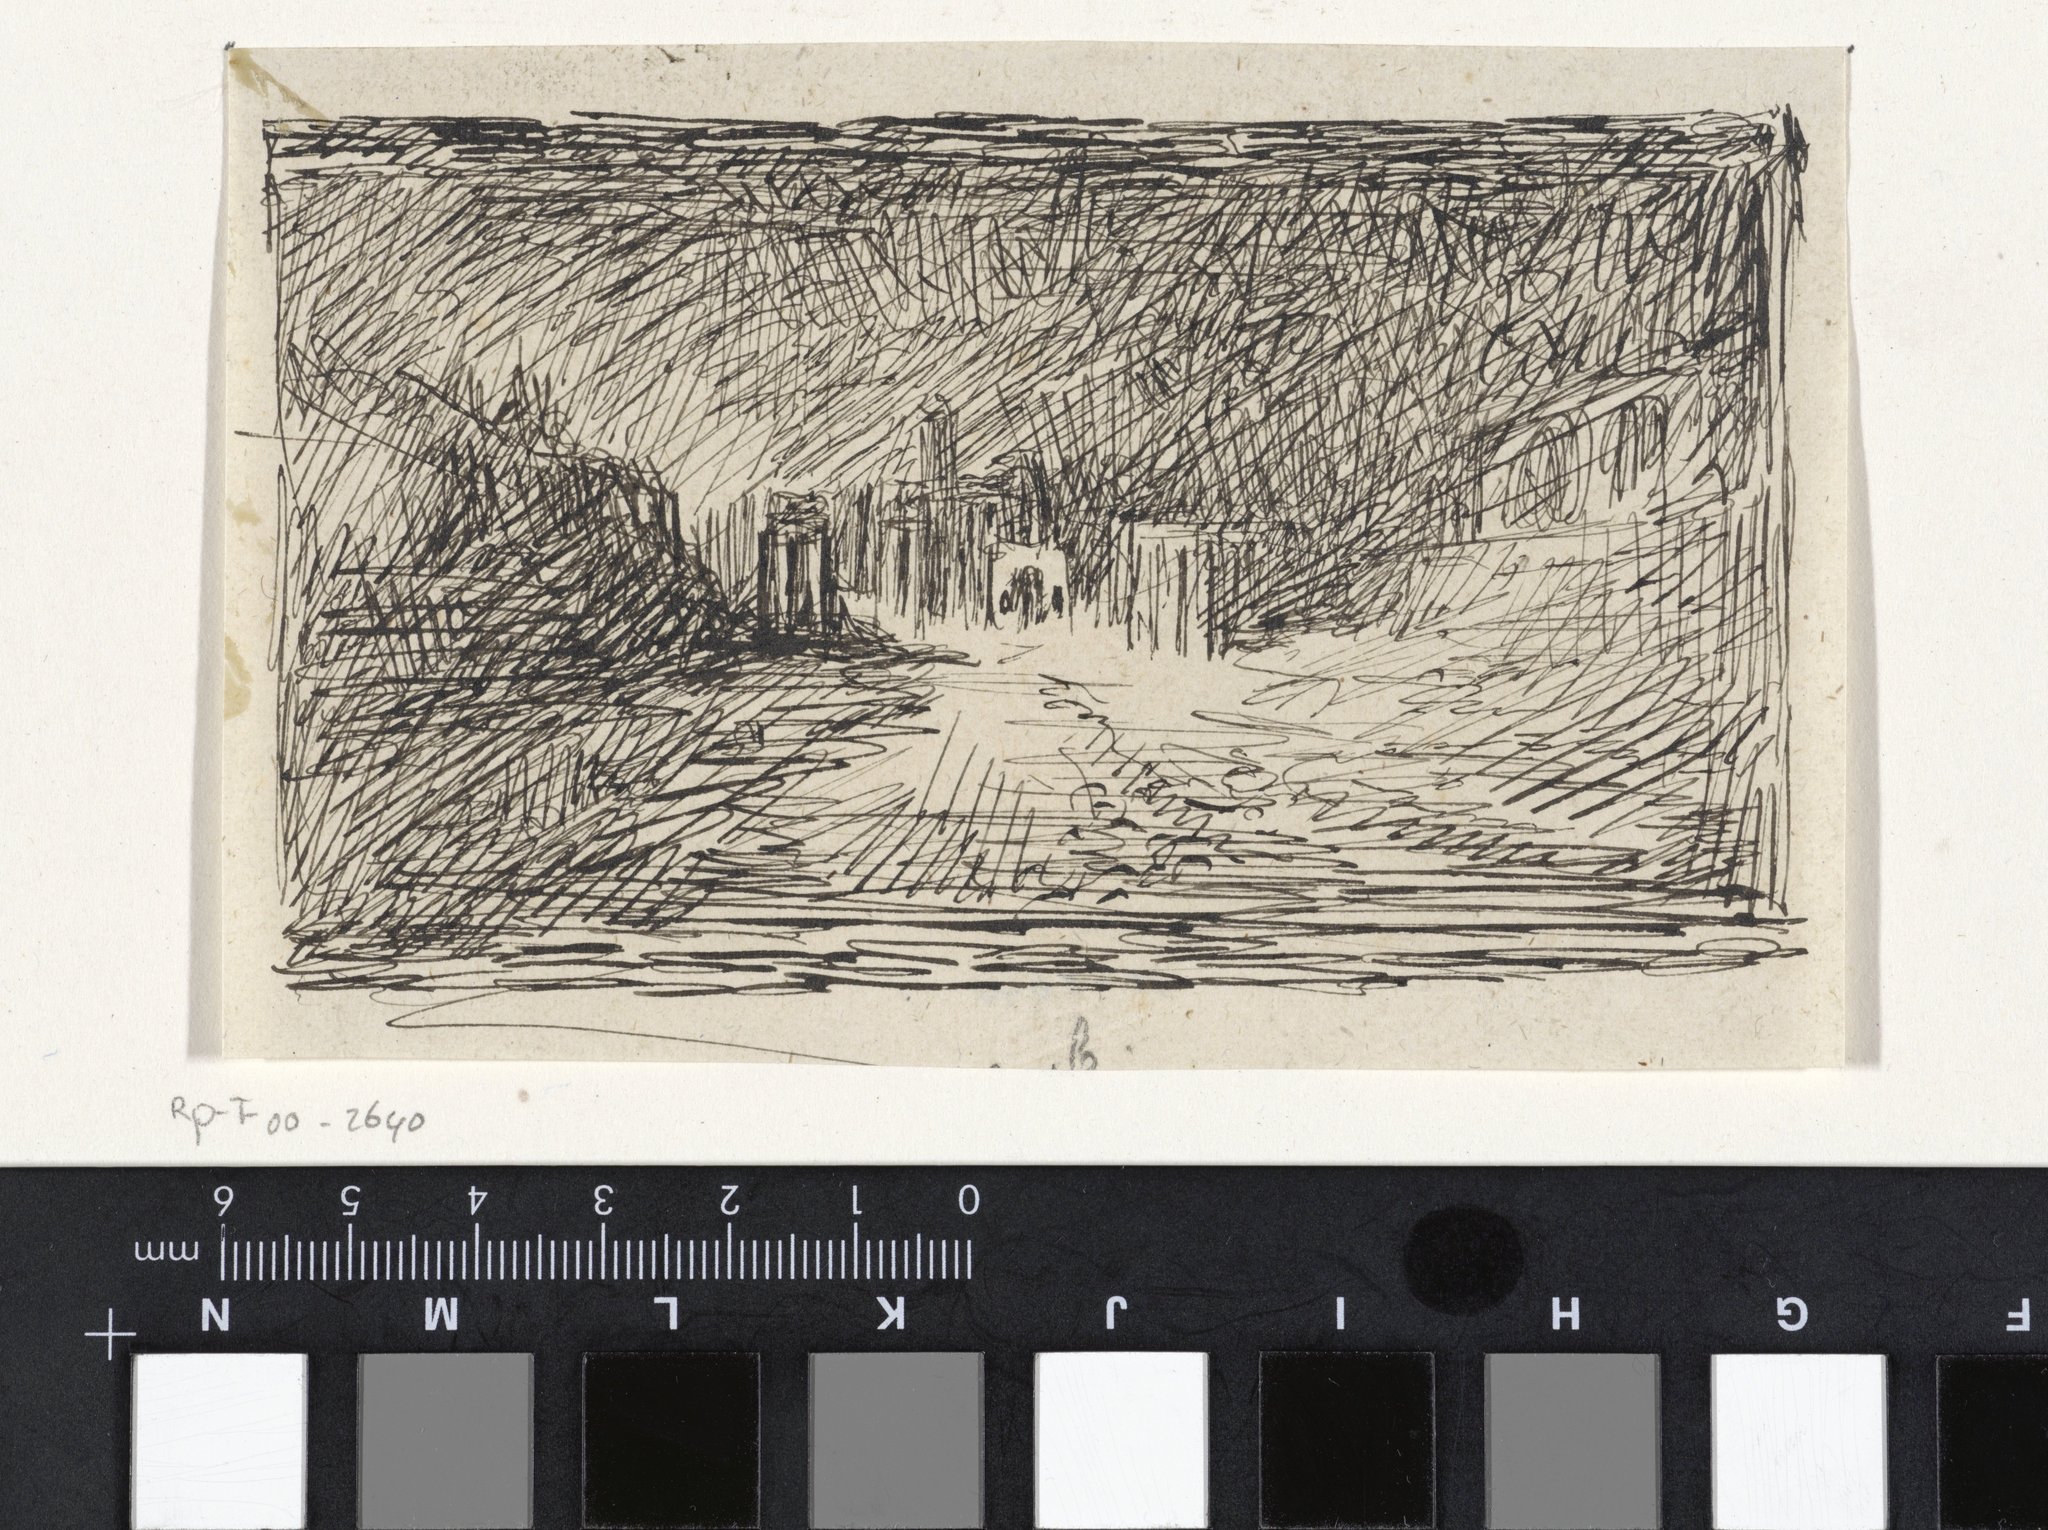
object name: drawing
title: Forum Romanum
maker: thomas cool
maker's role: draughtsman, painter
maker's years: 1851-1904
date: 1861-1904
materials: ink, paper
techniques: pen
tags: landscape with ruins, rome